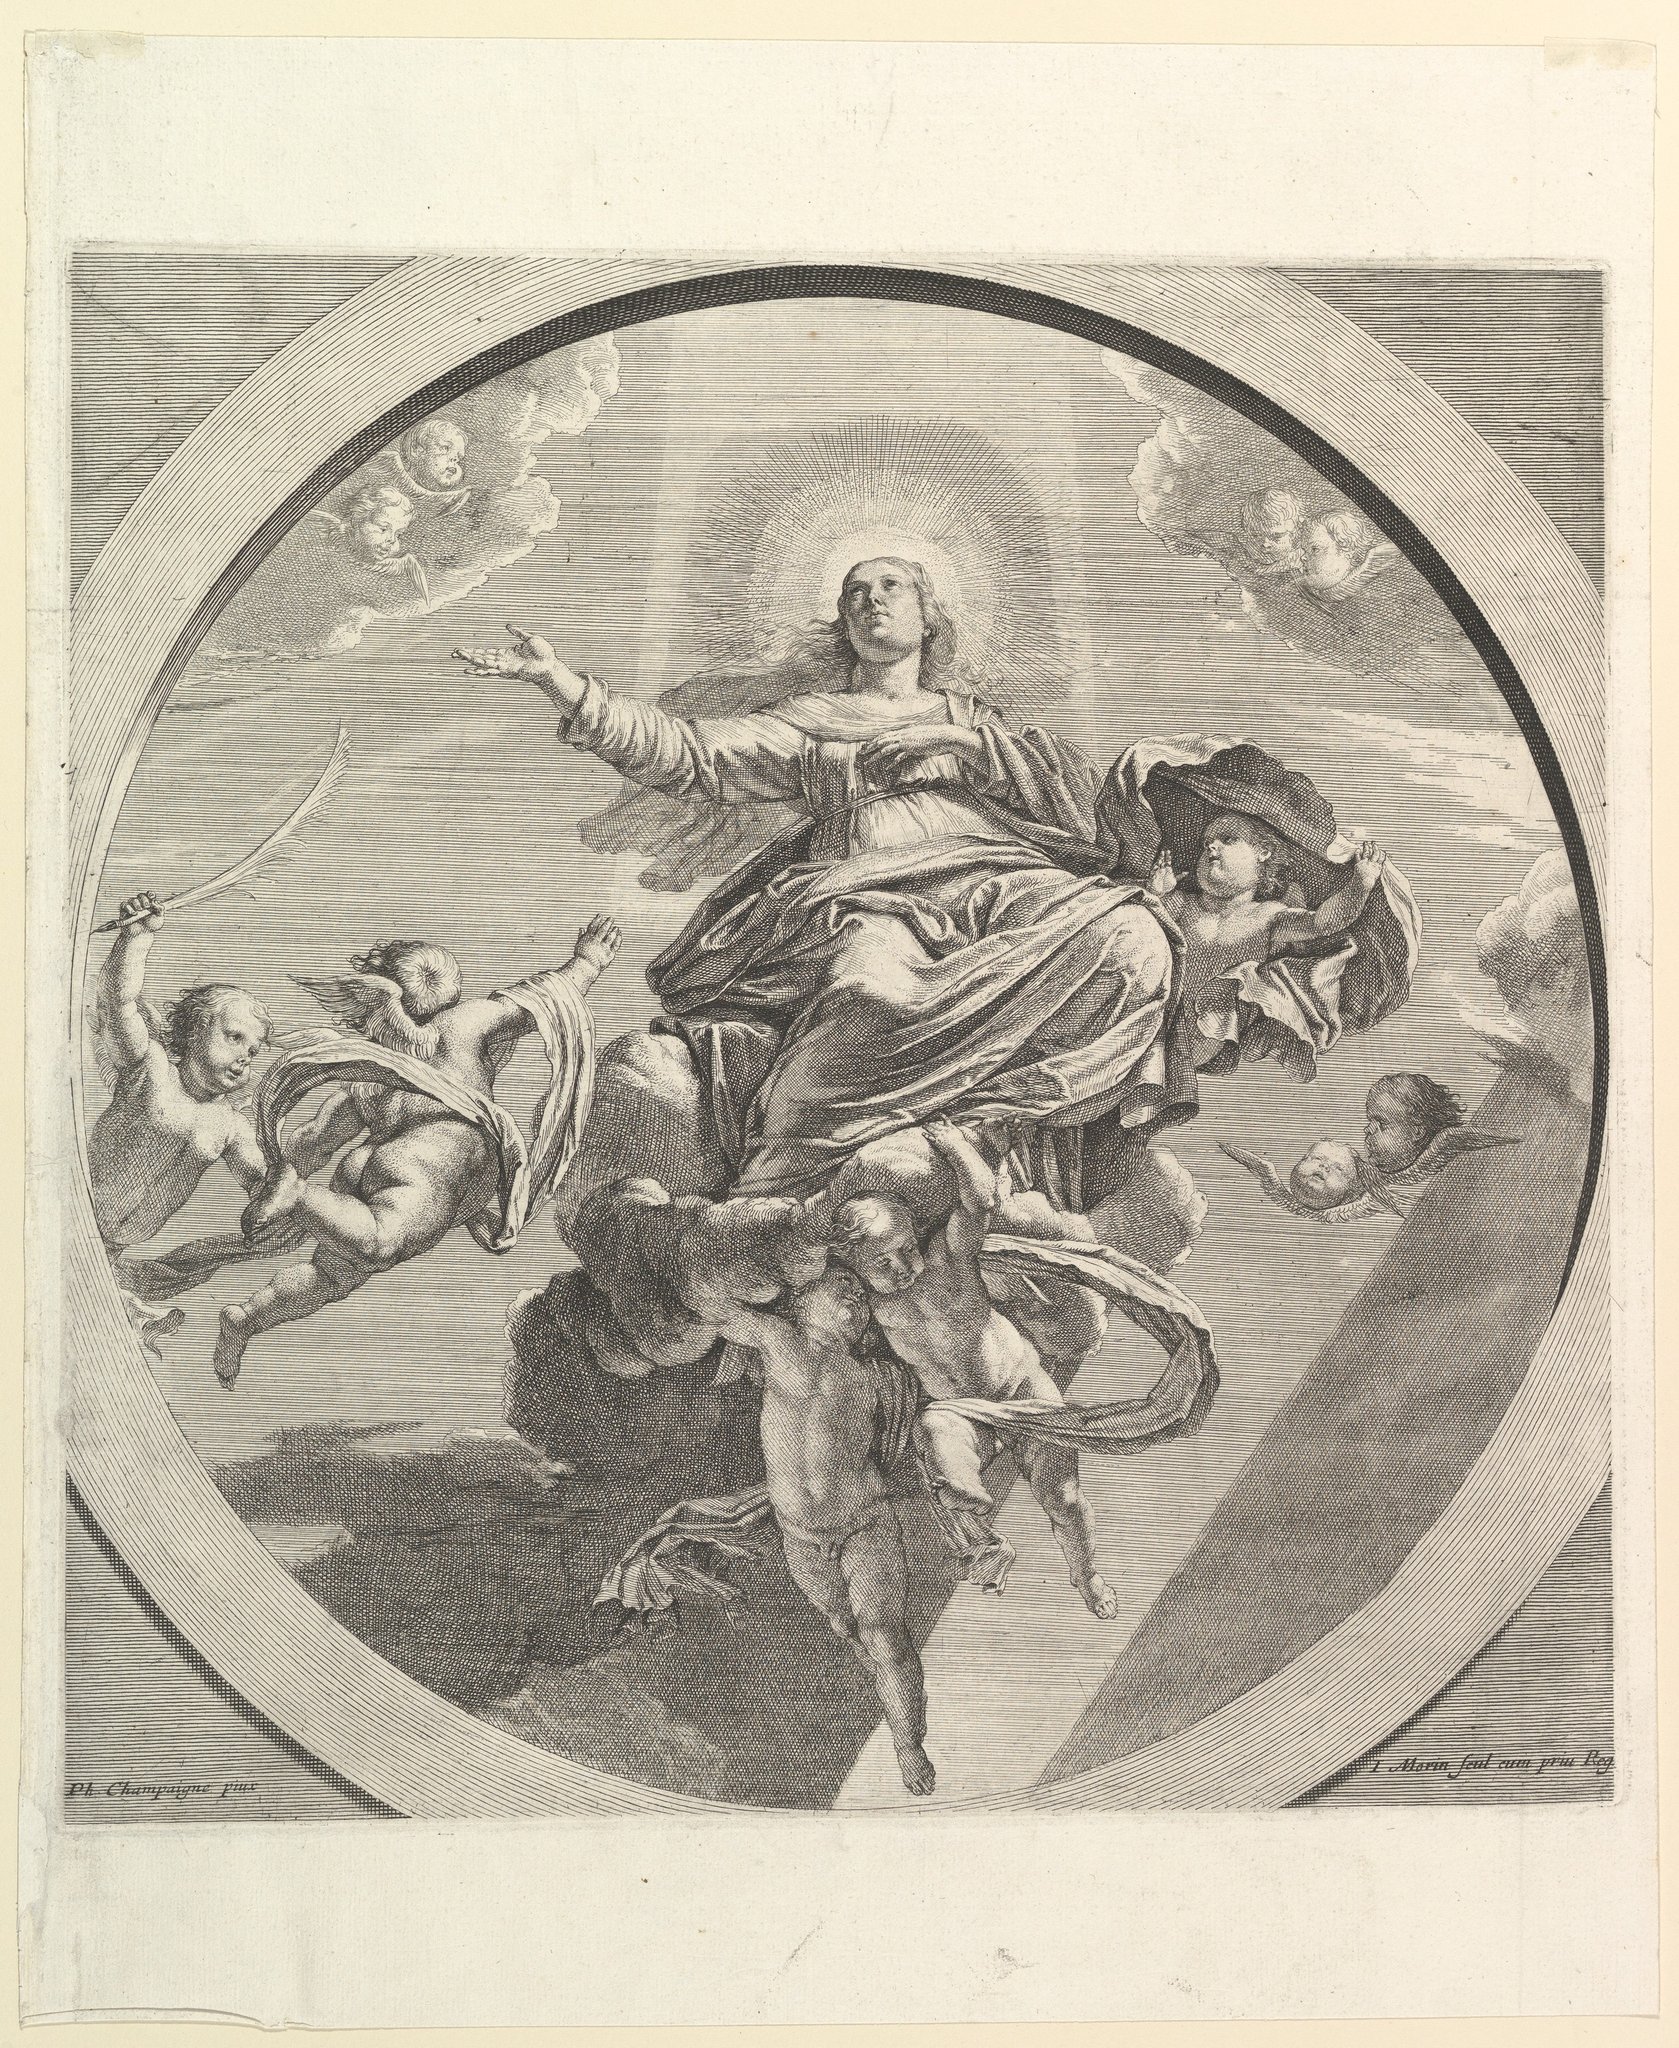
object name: print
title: L'Assomption de la Vierge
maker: jean morin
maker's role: artist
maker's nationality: french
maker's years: 1605-1650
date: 1605-1650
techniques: etching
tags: cupid,assumption of the virgin